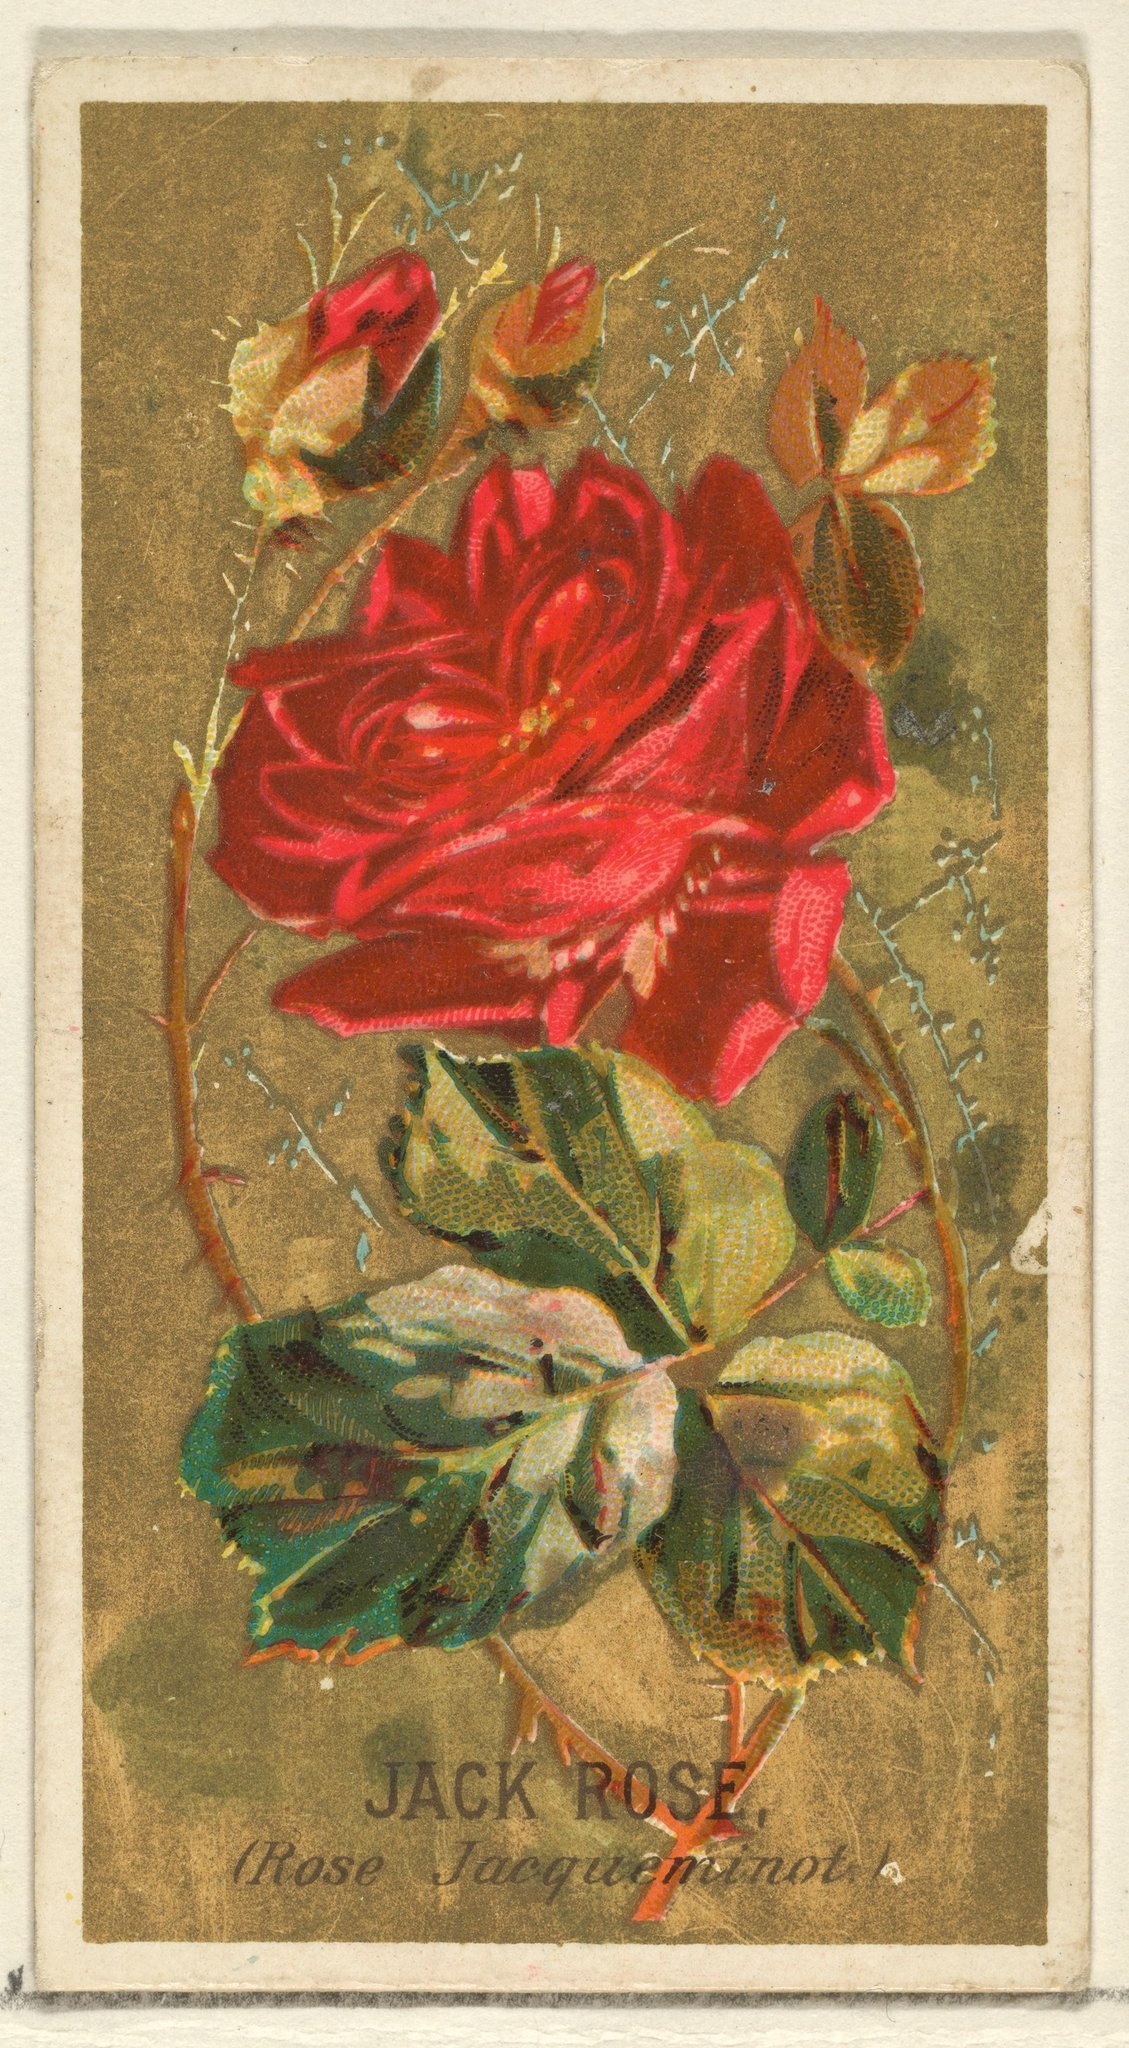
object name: print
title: Jack Rose (Rose Jacqueminot), from the Flowers series for Old Judge Cigarettes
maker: goodwin & company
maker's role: publisher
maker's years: 1850-1950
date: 1890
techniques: color lithograph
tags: roses,leaves